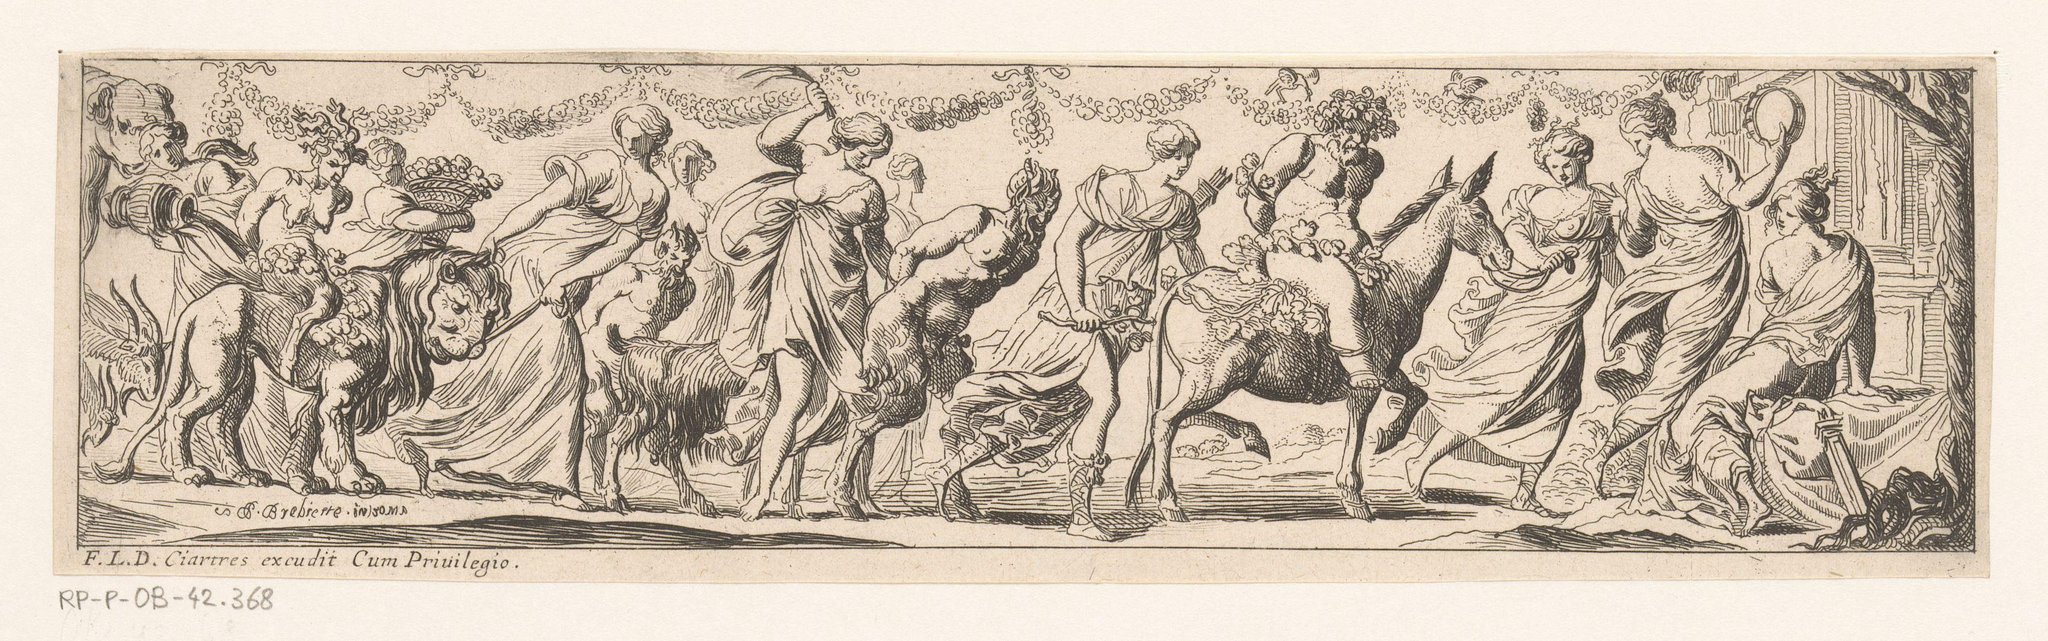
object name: print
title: Bacchus en zijn gevolg door nimfen gevangen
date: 1617-1626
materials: paper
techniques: etching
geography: rome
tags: (story of) bacchus (dionysus), liber, ass, donkey, nymphs (in general); 'ninfe in commune' (ripa), satyr(s) (in general), beasts of prey, predatory animals: lion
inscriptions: collector's mark: Lugt 240